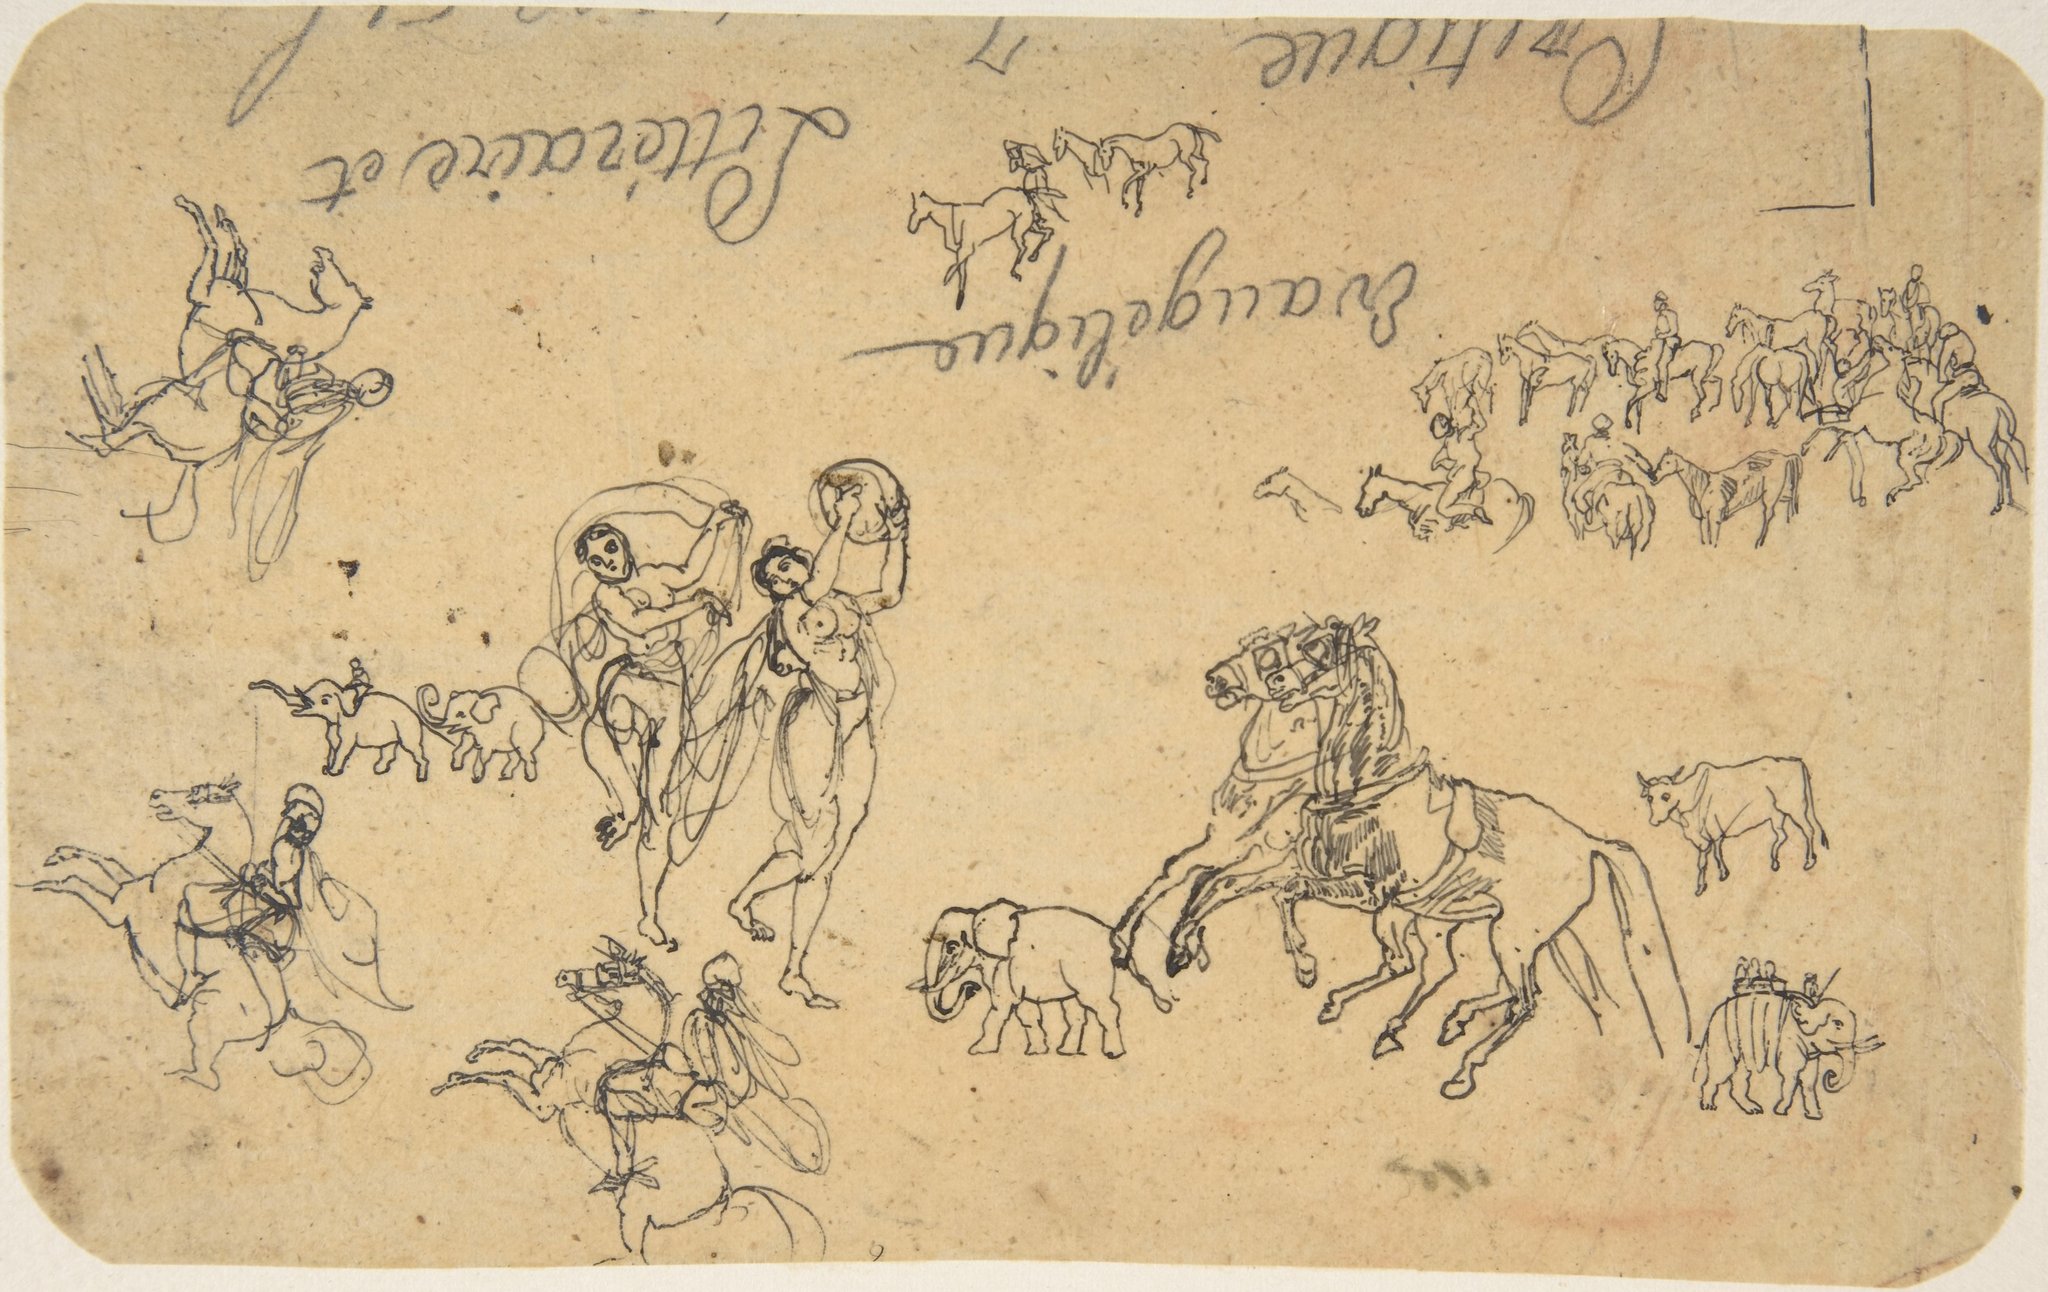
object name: drawing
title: Various Studies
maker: rodolphe bresdin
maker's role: artist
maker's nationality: french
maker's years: 1822-1885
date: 1822-1885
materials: graphite, ink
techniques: pen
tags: animals,women,elephants,horses